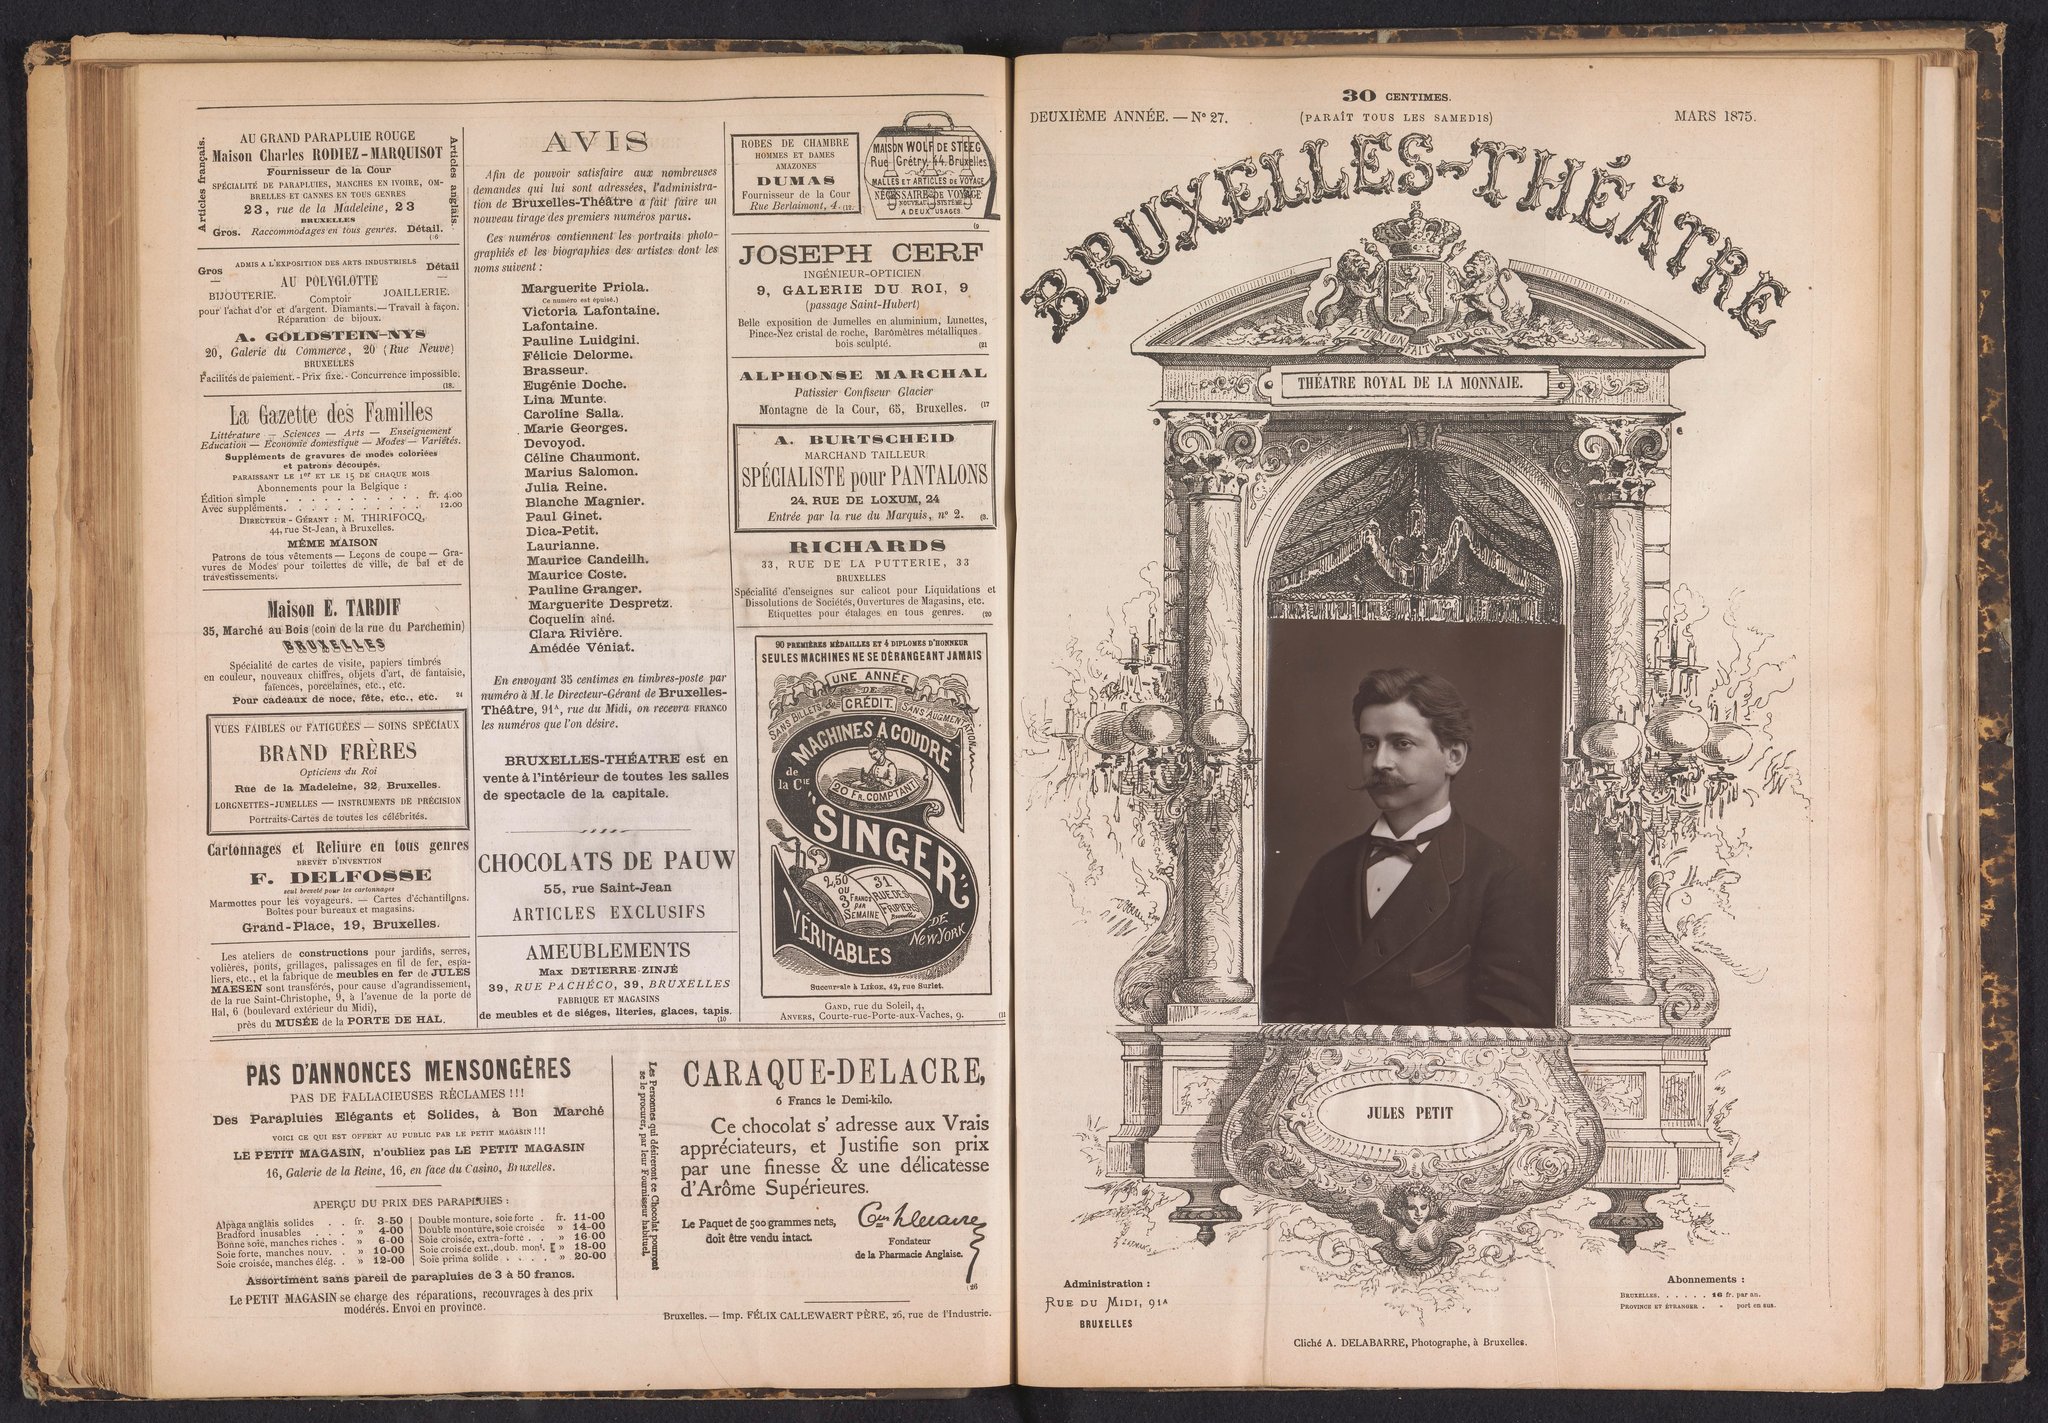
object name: photomechanical print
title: Jules Petit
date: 1870-1875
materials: paper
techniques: woodburytype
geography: brussels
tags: portrait of actor, actress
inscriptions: number: ‘No 27.’